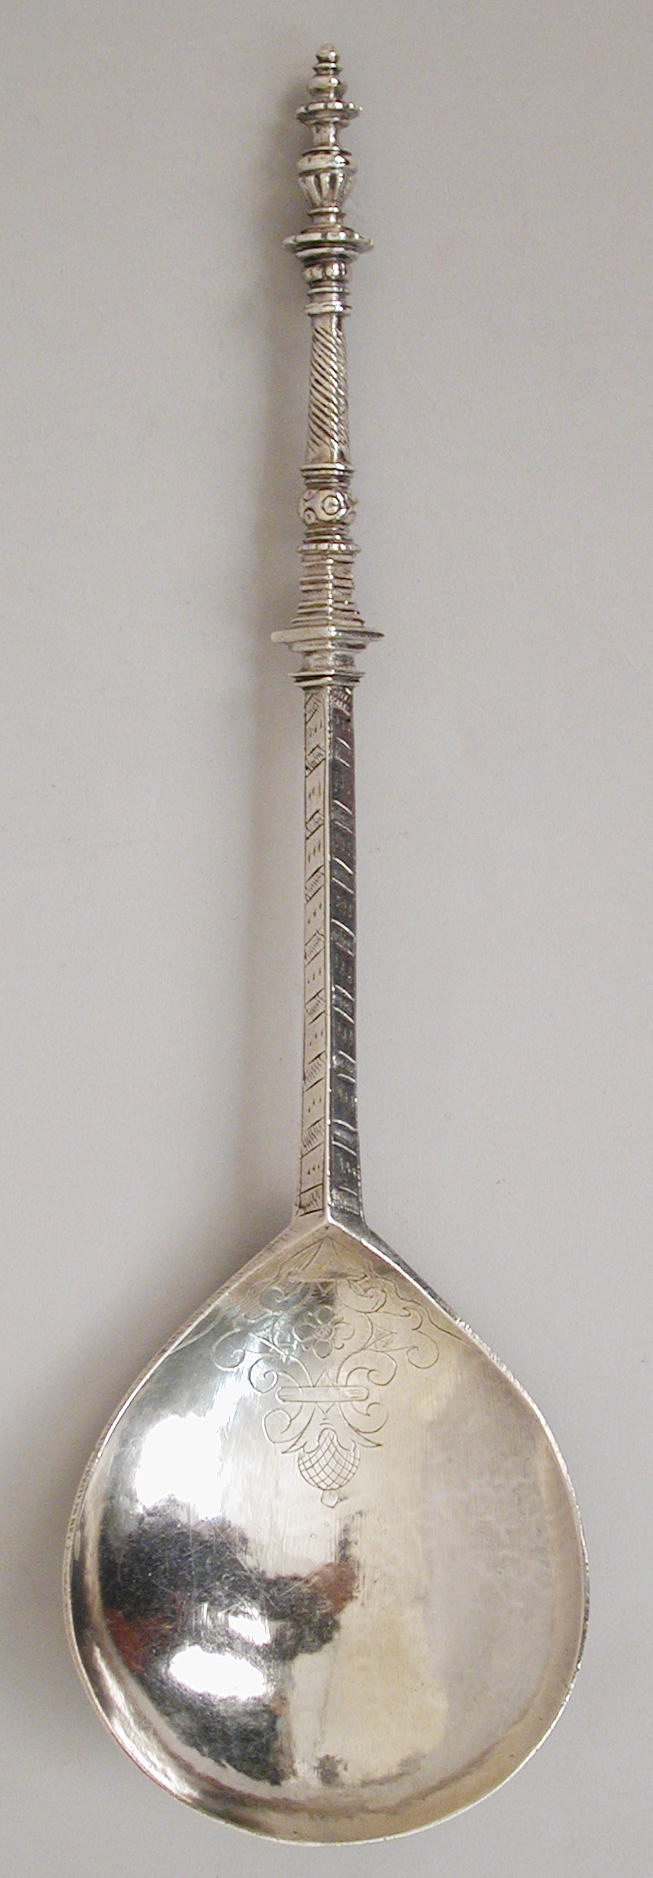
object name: spoon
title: Baluster top spoon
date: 1601-1625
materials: silver